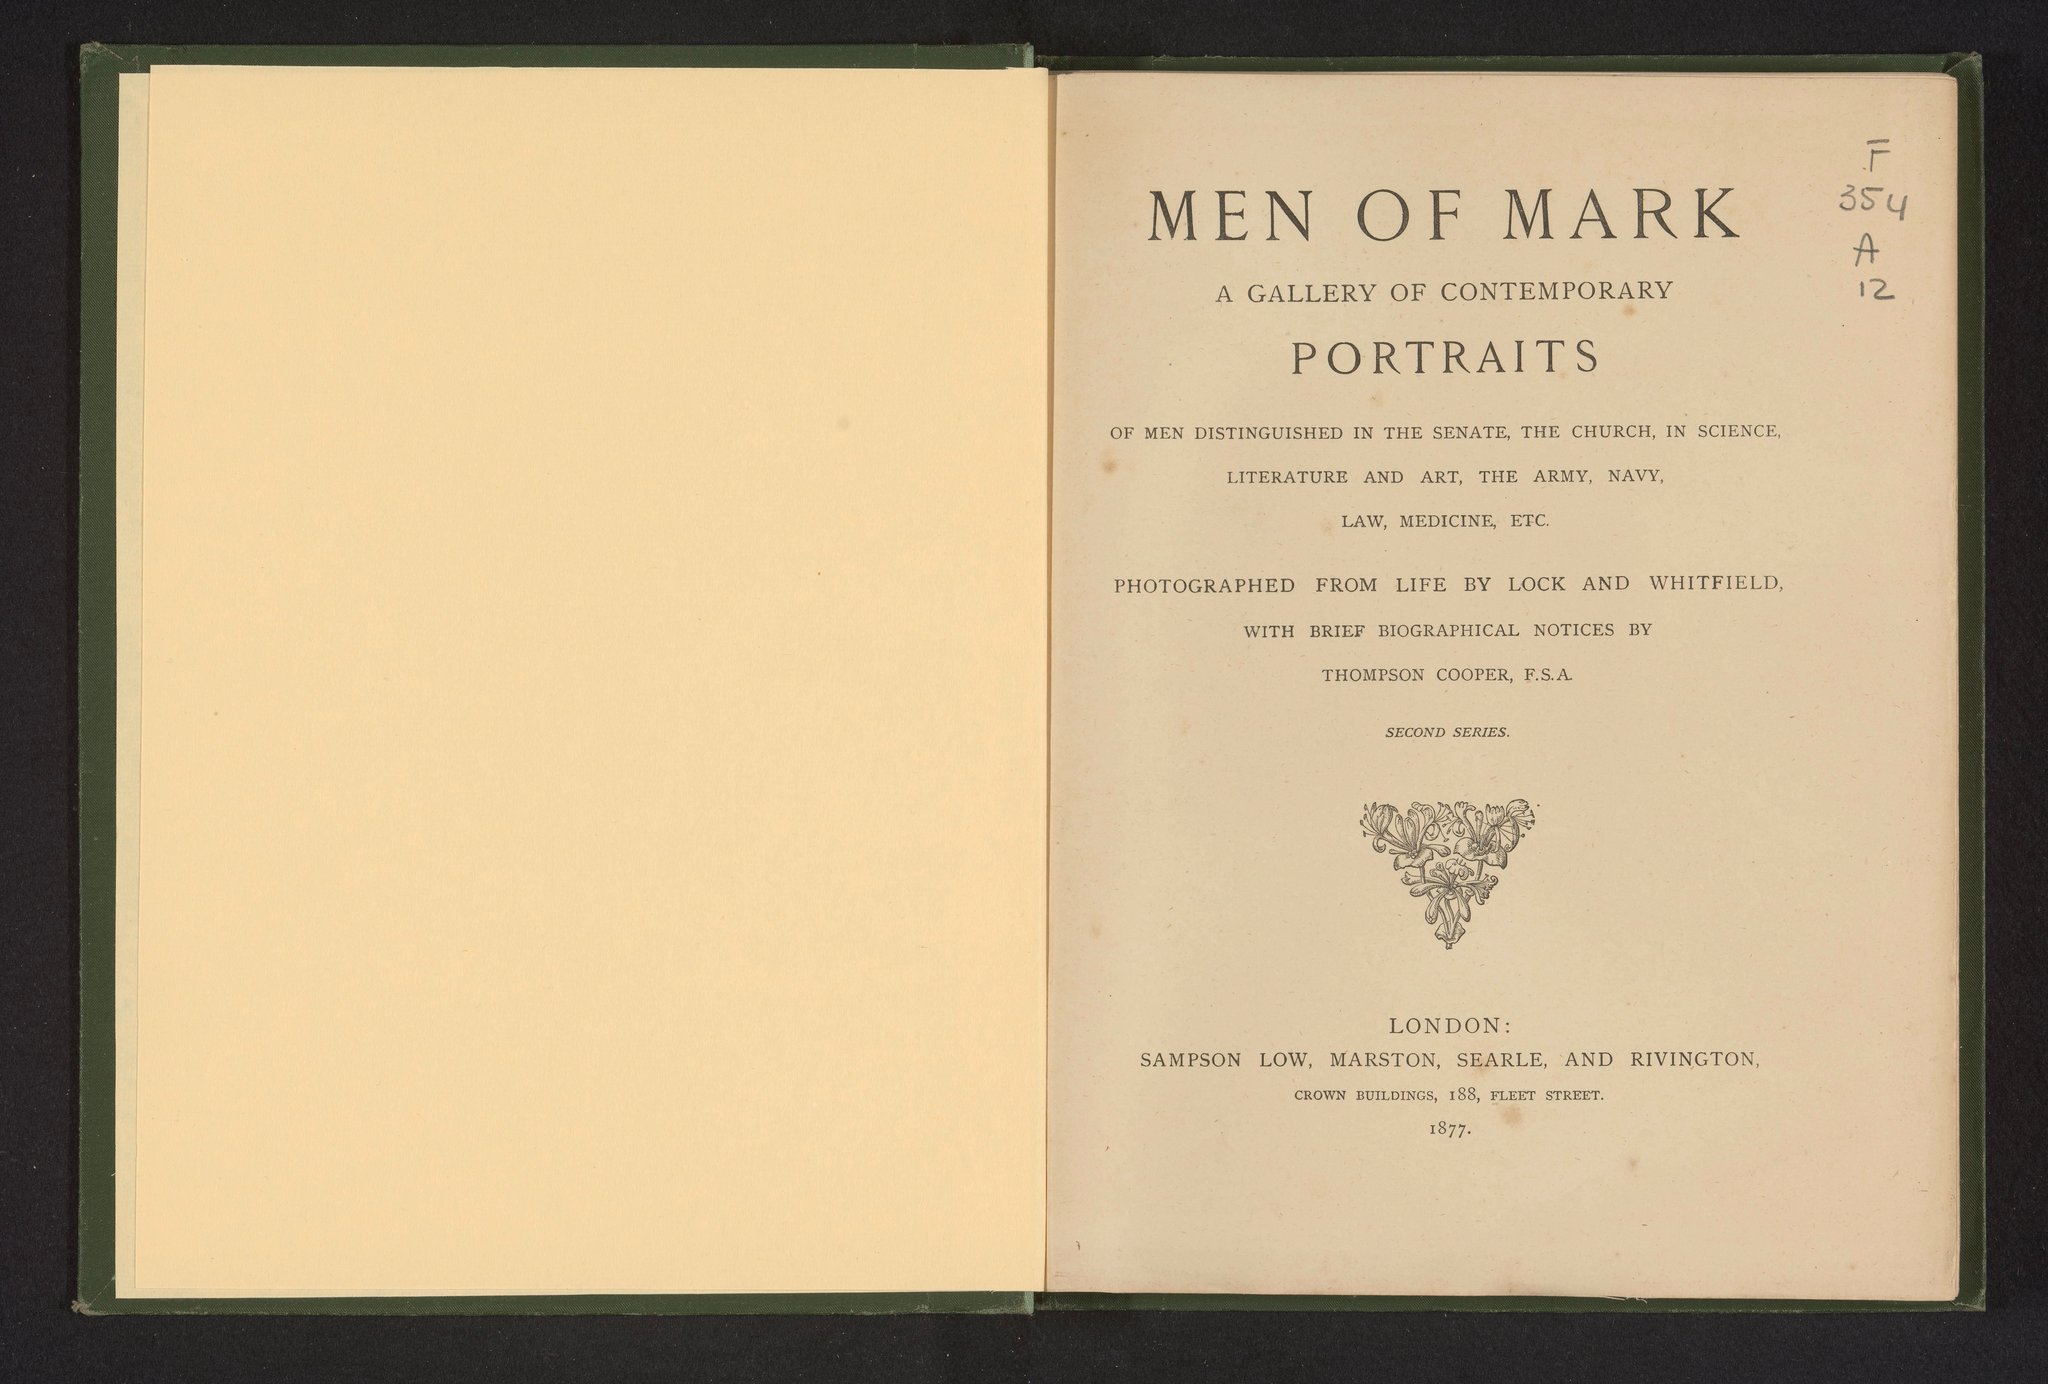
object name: book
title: Men of mark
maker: thompson cooper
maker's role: schrijver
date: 1877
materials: cardboard, linen, paper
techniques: printing, woodburytype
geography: london